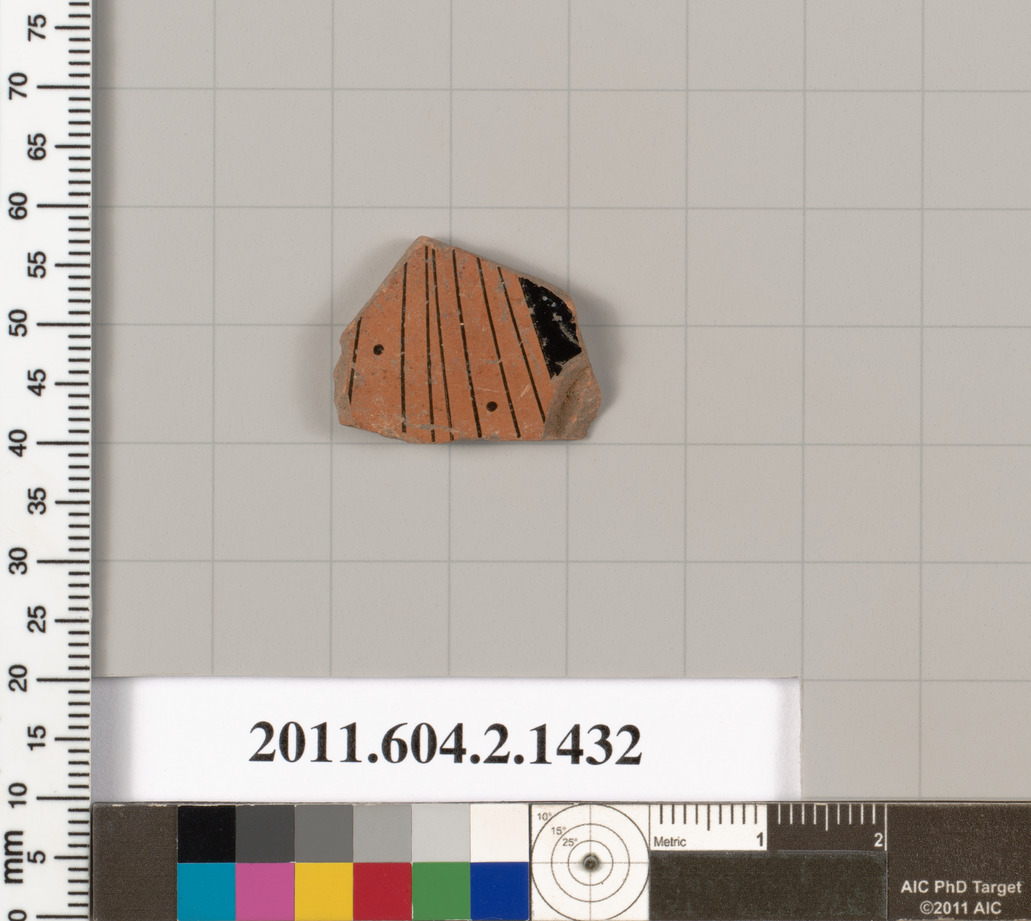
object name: skyphos fragment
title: Terracotta fragment of a skyphos (deep drinking cup)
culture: greek, attic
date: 480-470 BCE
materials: terracotta